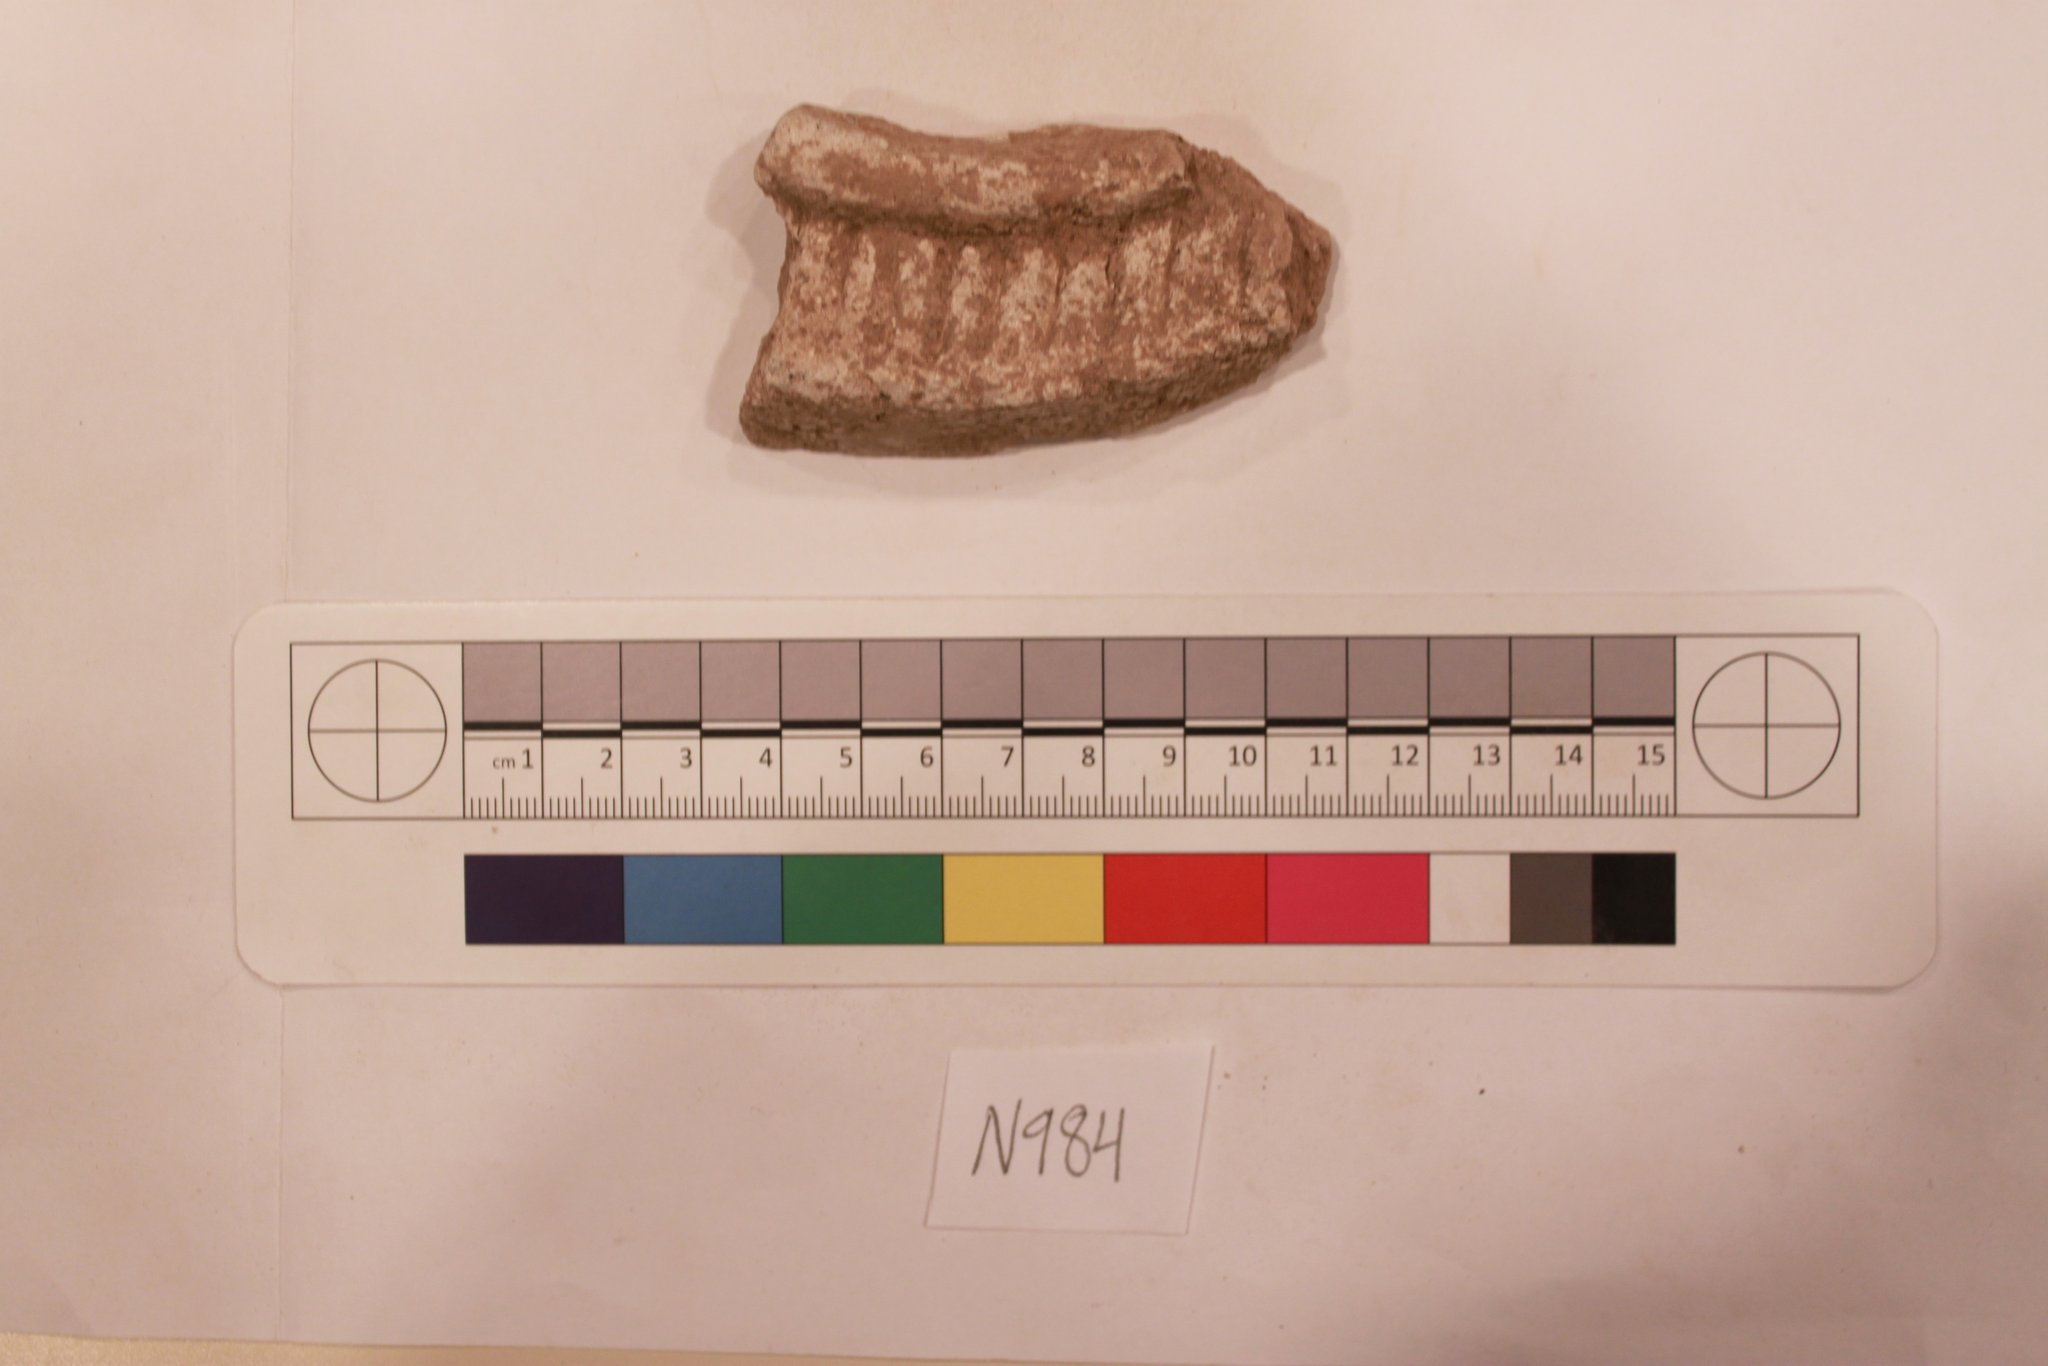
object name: fragment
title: Stucco Fragment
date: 701-1200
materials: plaster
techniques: carving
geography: iran